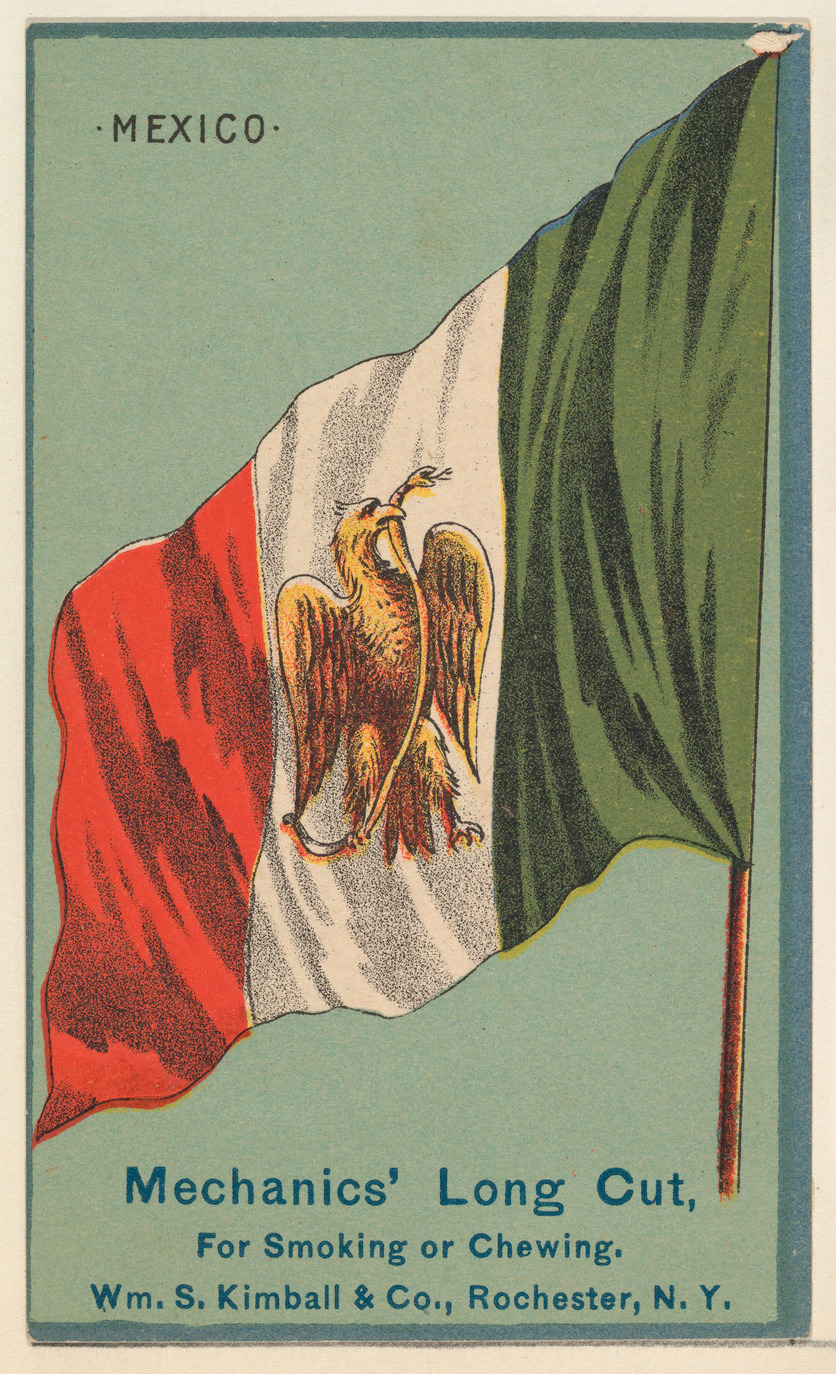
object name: print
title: Mexico, from the National Flags series (N195) issued by Wm. S. Kimball & Co.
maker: william s. kimball & company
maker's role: publisher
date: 1891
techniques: color lithograph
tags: eagles,snakes,flags